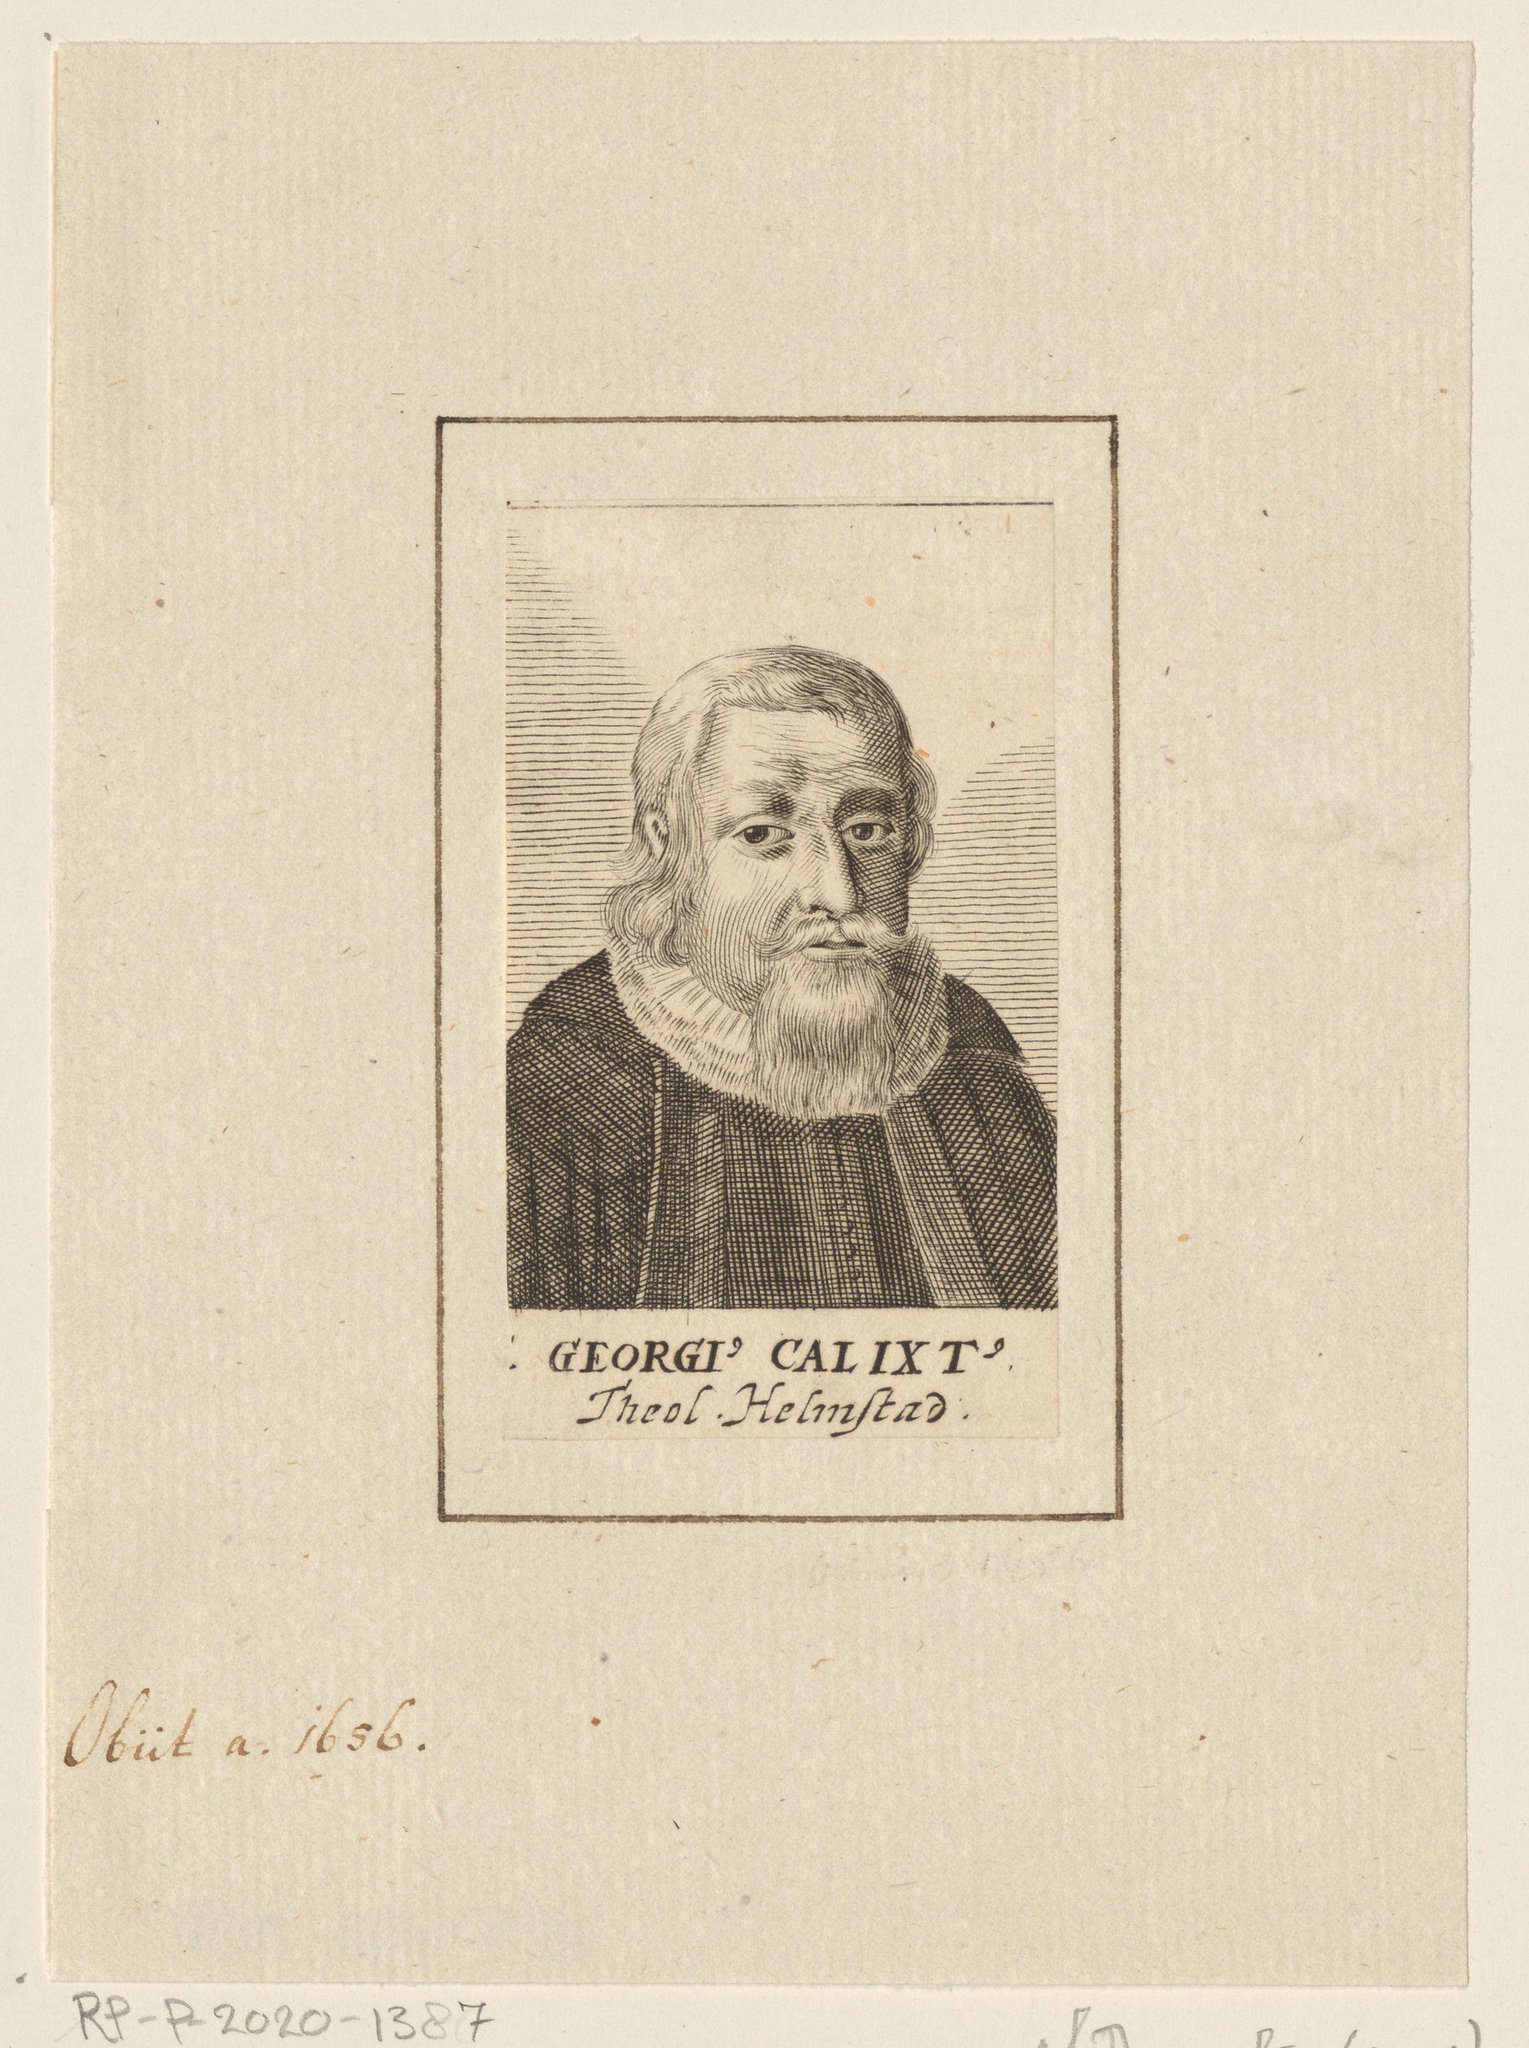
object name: book illustration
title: Georgi Calixt Theol. Helmstad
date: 1688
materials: paper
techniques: engraving, etching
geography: nuremberg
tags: historical persons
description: Prent uit: Freher, Paul. Theatrum virorum eruditione clarorum. Neurenberg: Johann Hoffmann, 1688.